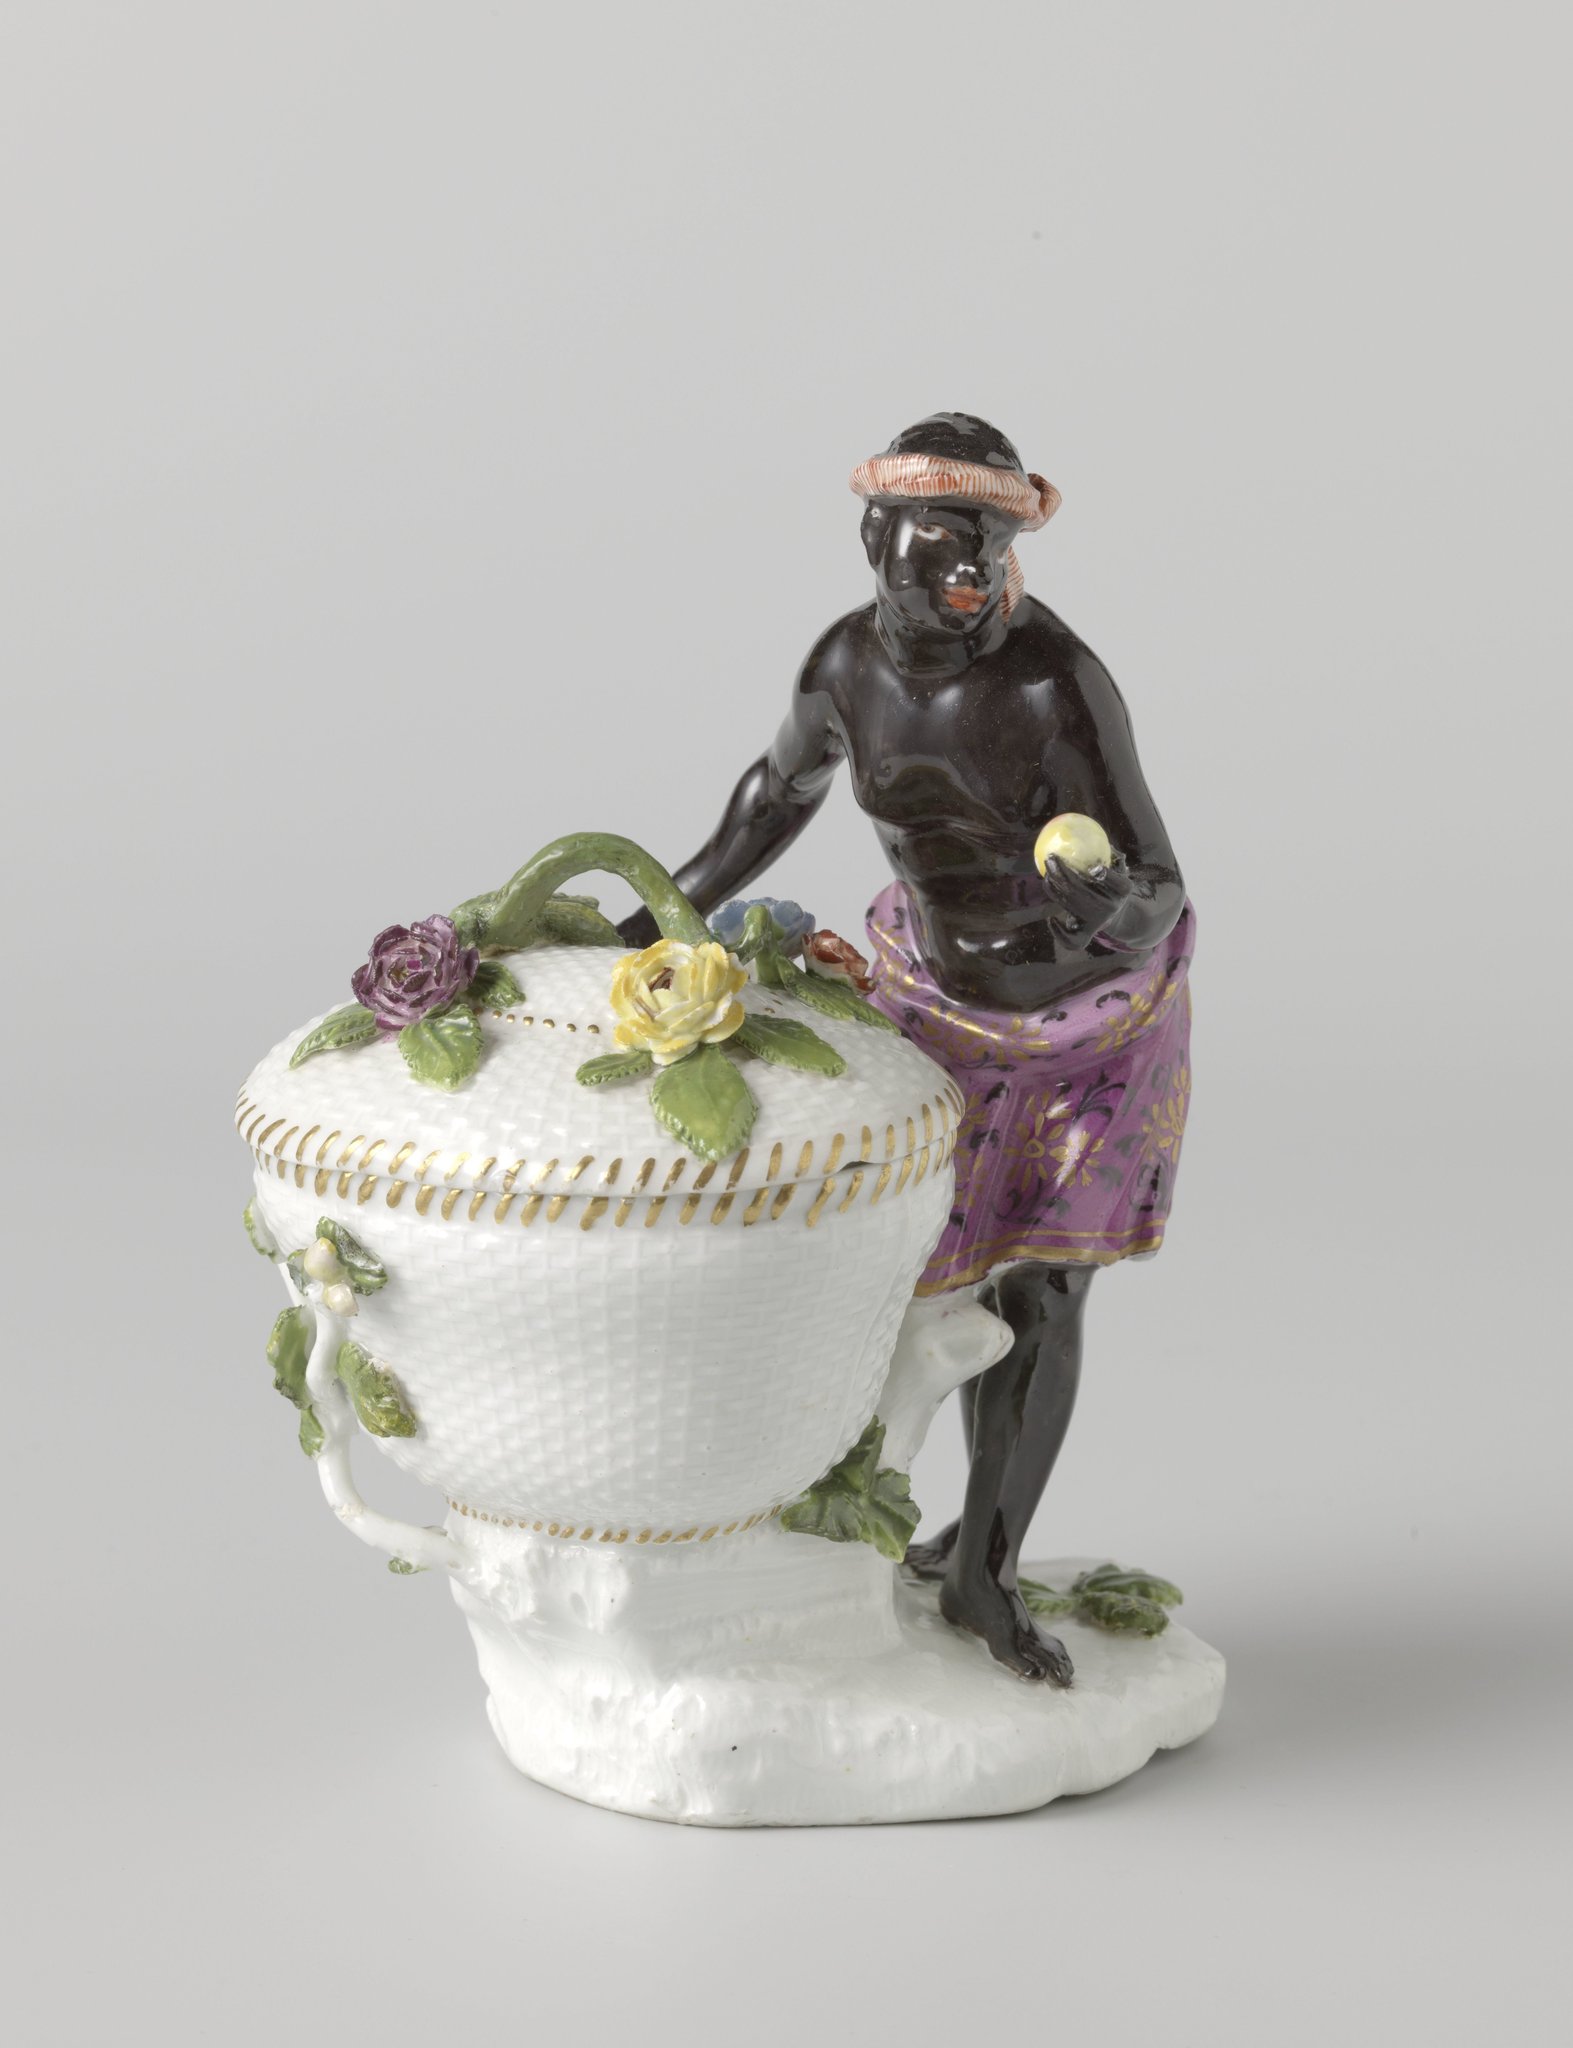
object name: eating drinking utensil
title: Suikerpot in de vorm van een vrouw bij een mand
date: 1741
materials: porcelain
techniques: painted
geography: meissen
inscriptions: factory mark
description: Deksel van suikerpot van porselein, in de vorm van een vrouw met naast zich een mand met deksel op een grond met bladeren. De vrouw draagt een rok, violet met bloemtakken in zwart en goud en een rood gestreepte hoofddoek om het haar. In de linkerhand heeft zij een appel. Op het deksel en de wand van de mand is een tak met veelkleurige bloemen aangebracht. Het beeld is gemerkt.